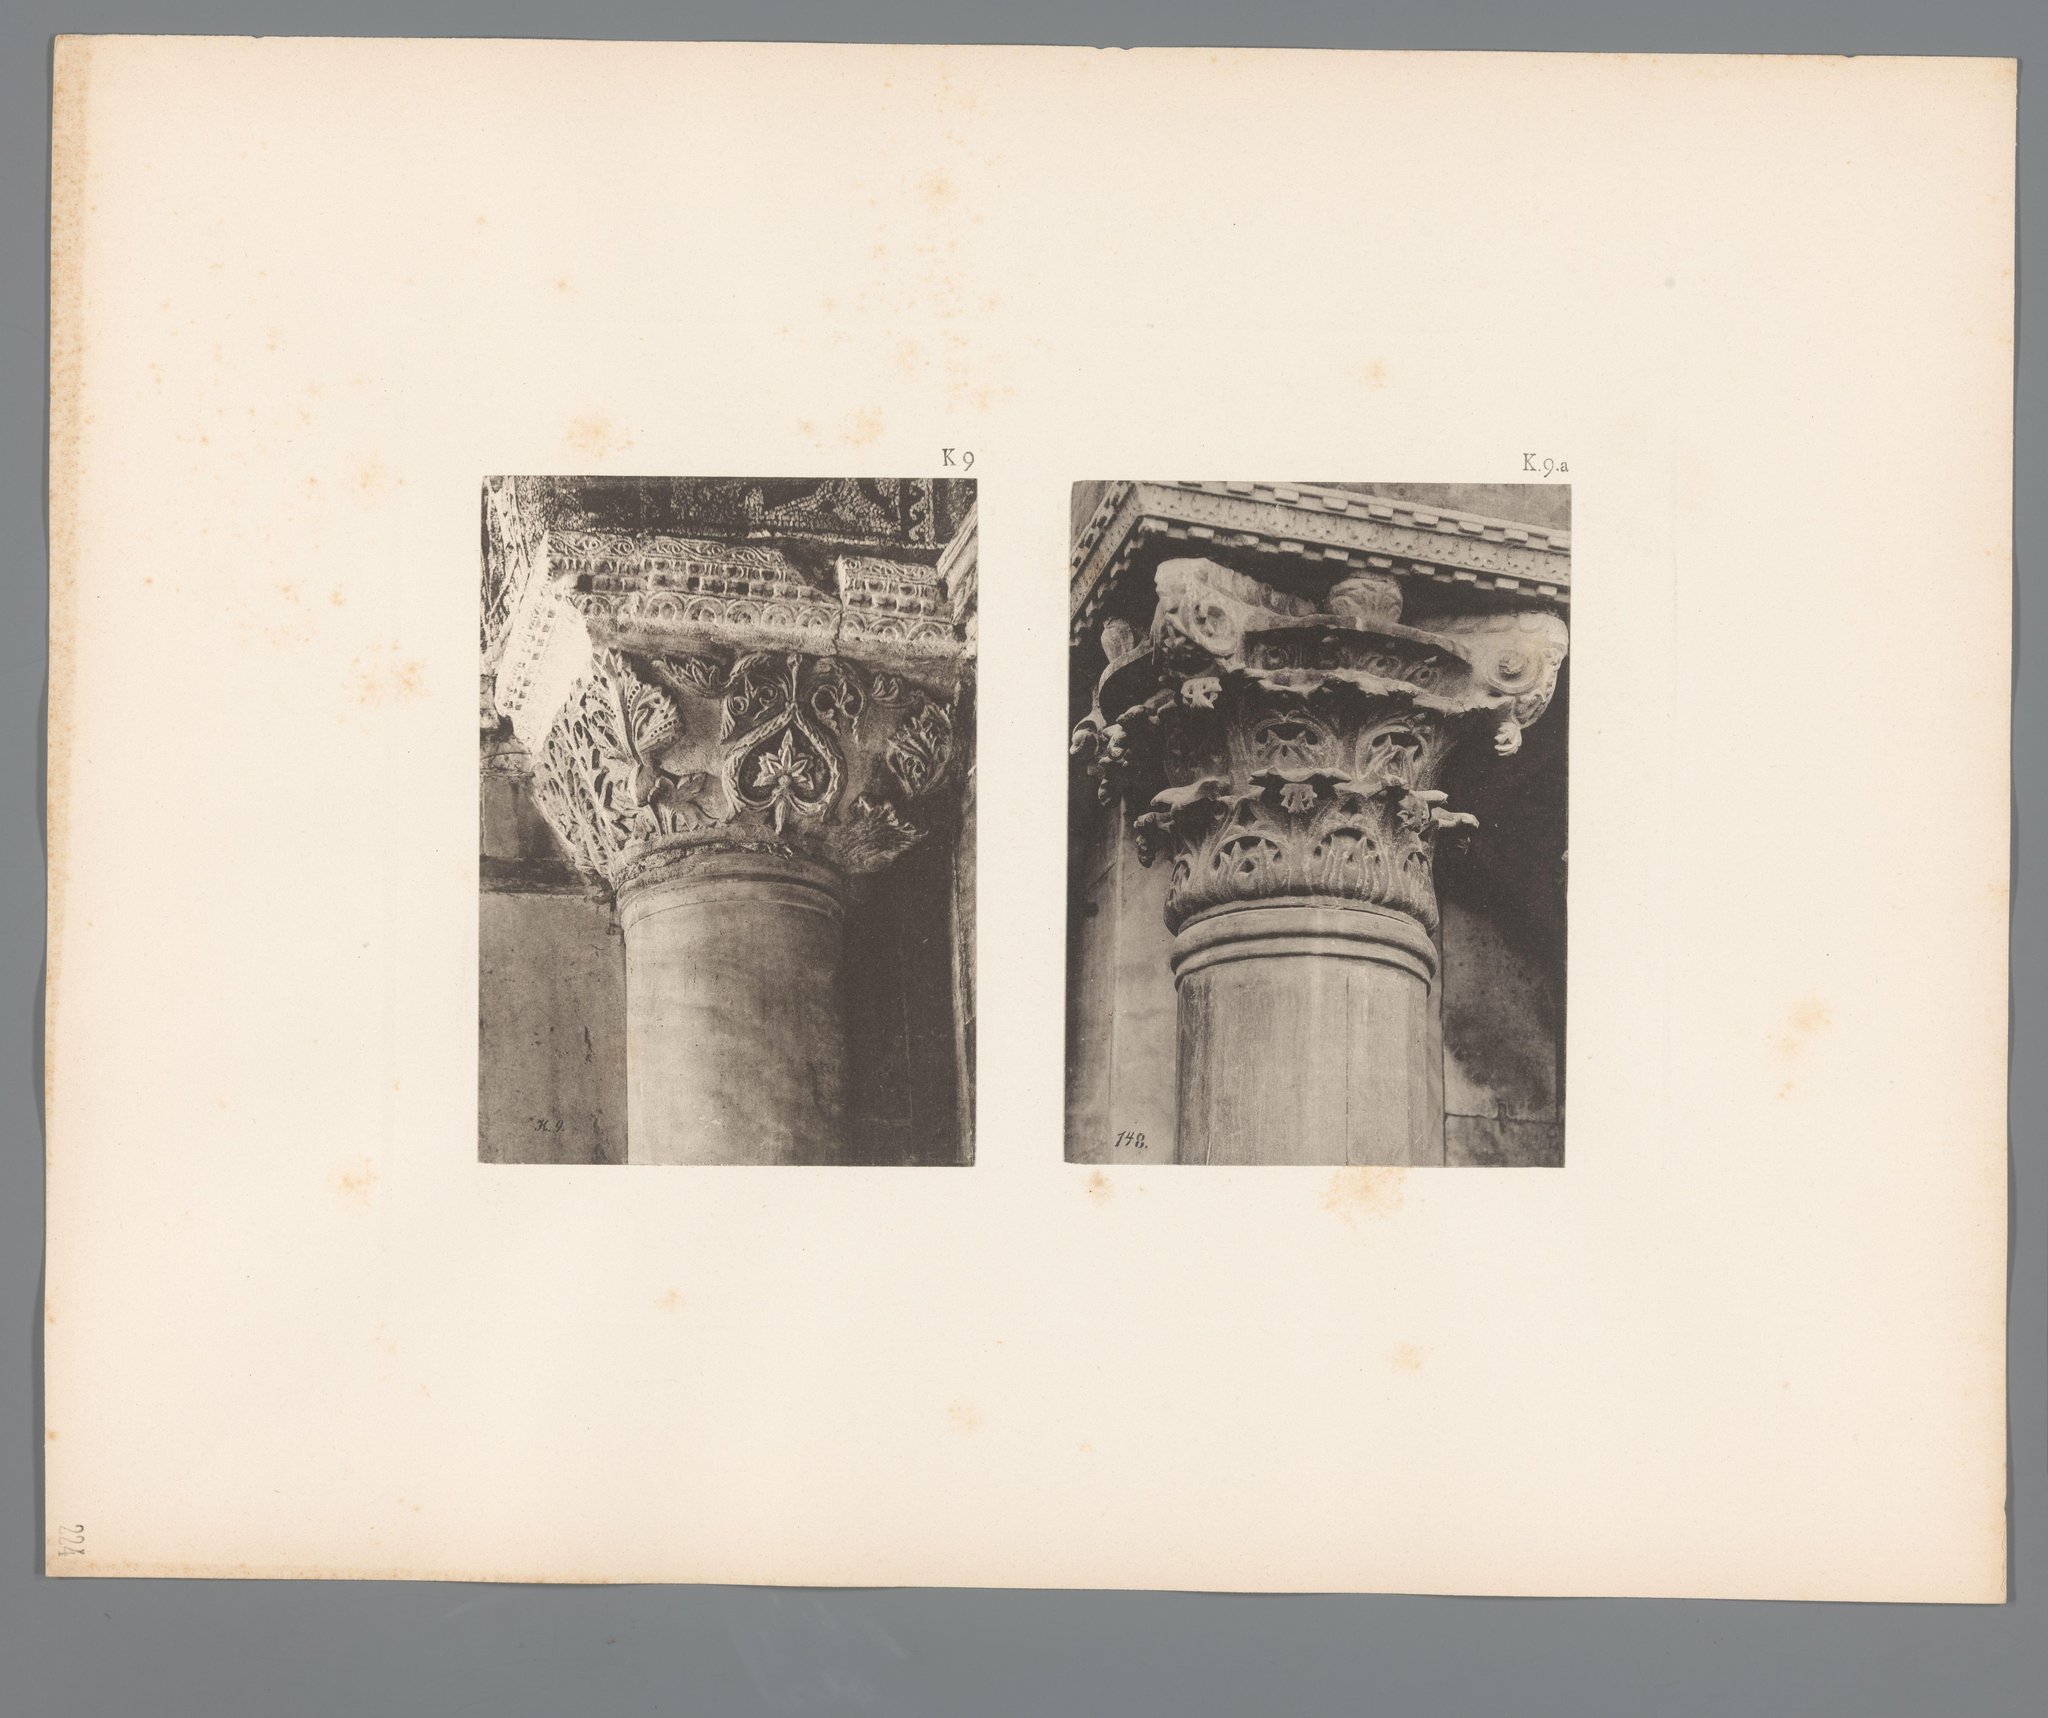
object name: photomechanical print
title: Twee afbeeldingen van Korinthische kapitelen van de San Marco in Venetië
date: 1880-1885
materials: paper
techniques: photograph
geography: venice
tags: capital (~ column, pillar) (+ classical art), church (exterior), corinthian order ~ architecture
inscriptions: number: ‘K.9.’, number: ‘148’, number: ‘K.9’, number: ‘K.9a’, number: ‘224’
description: Deze prenten maken deel uit van een omslag met 79 prenten op 53 bladen en 2 tekstbladen.